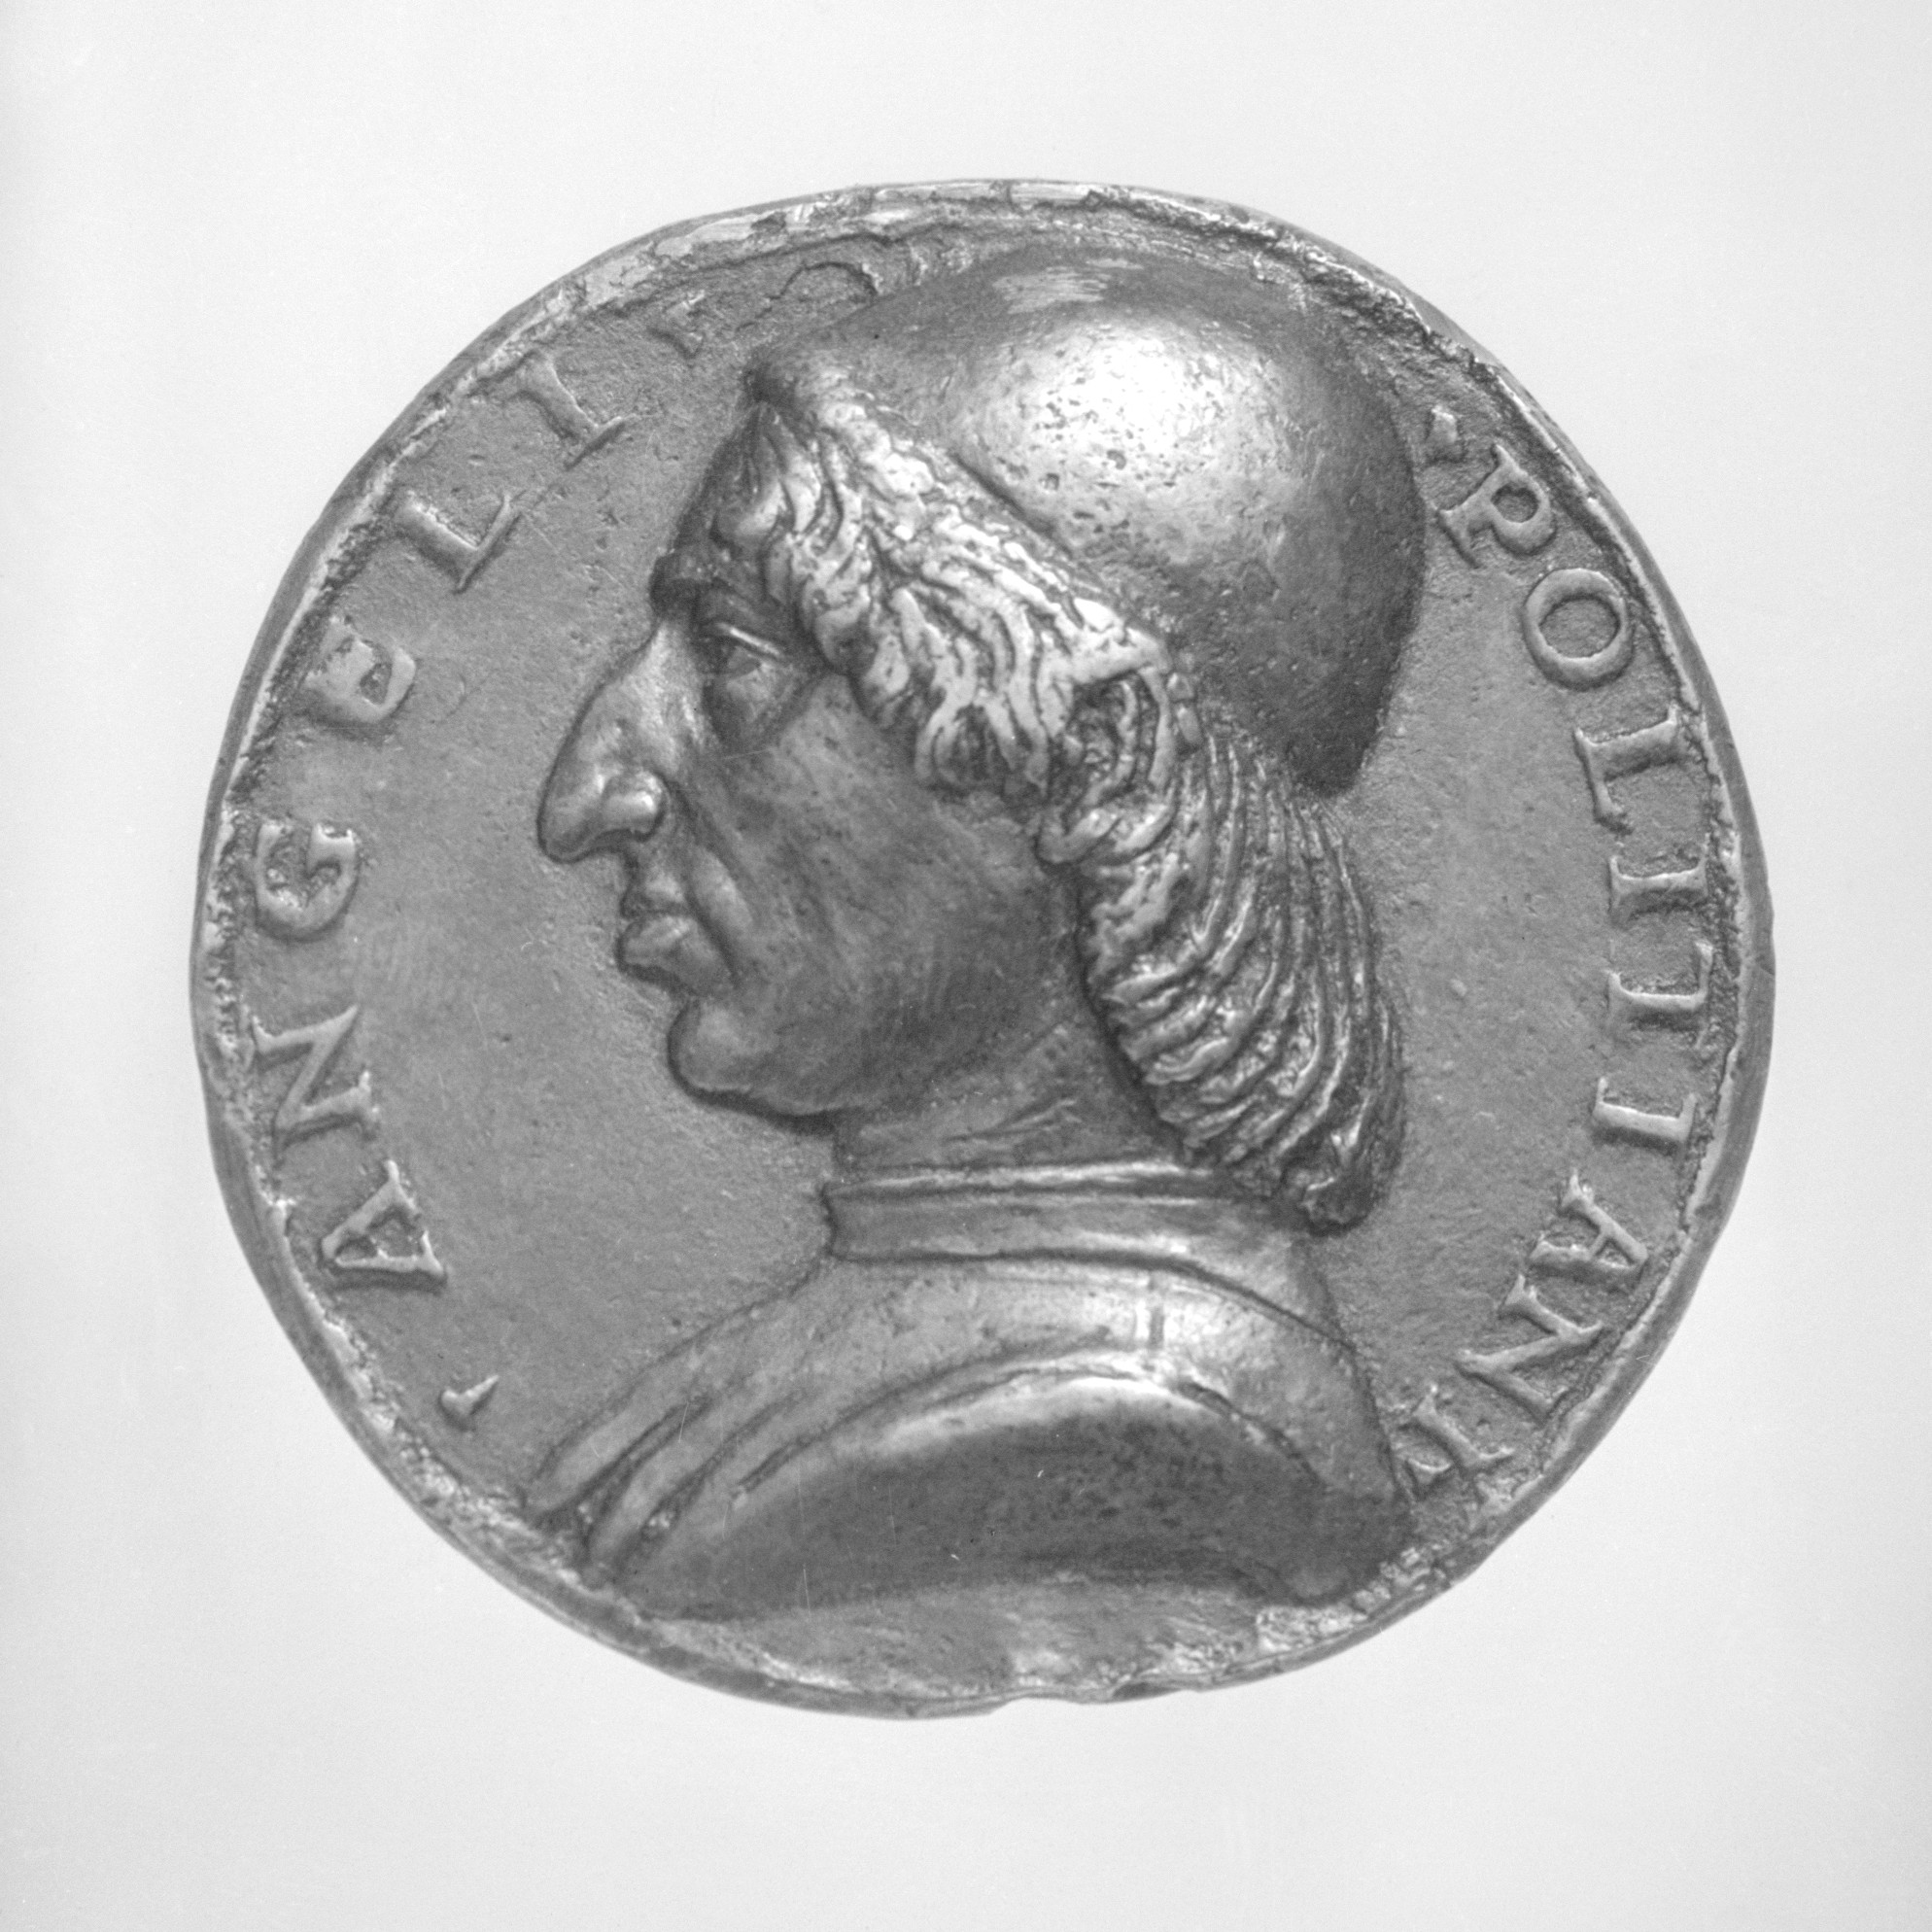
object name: medal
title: Angelo Poliziano (1454–1494) and Maria Poliziana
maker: niccolò fiorentino (niccolò di forzore spinelli)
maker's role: maker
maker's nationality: italian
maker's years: 1430-1514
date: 1401-1500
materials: bronze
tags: men,profiles